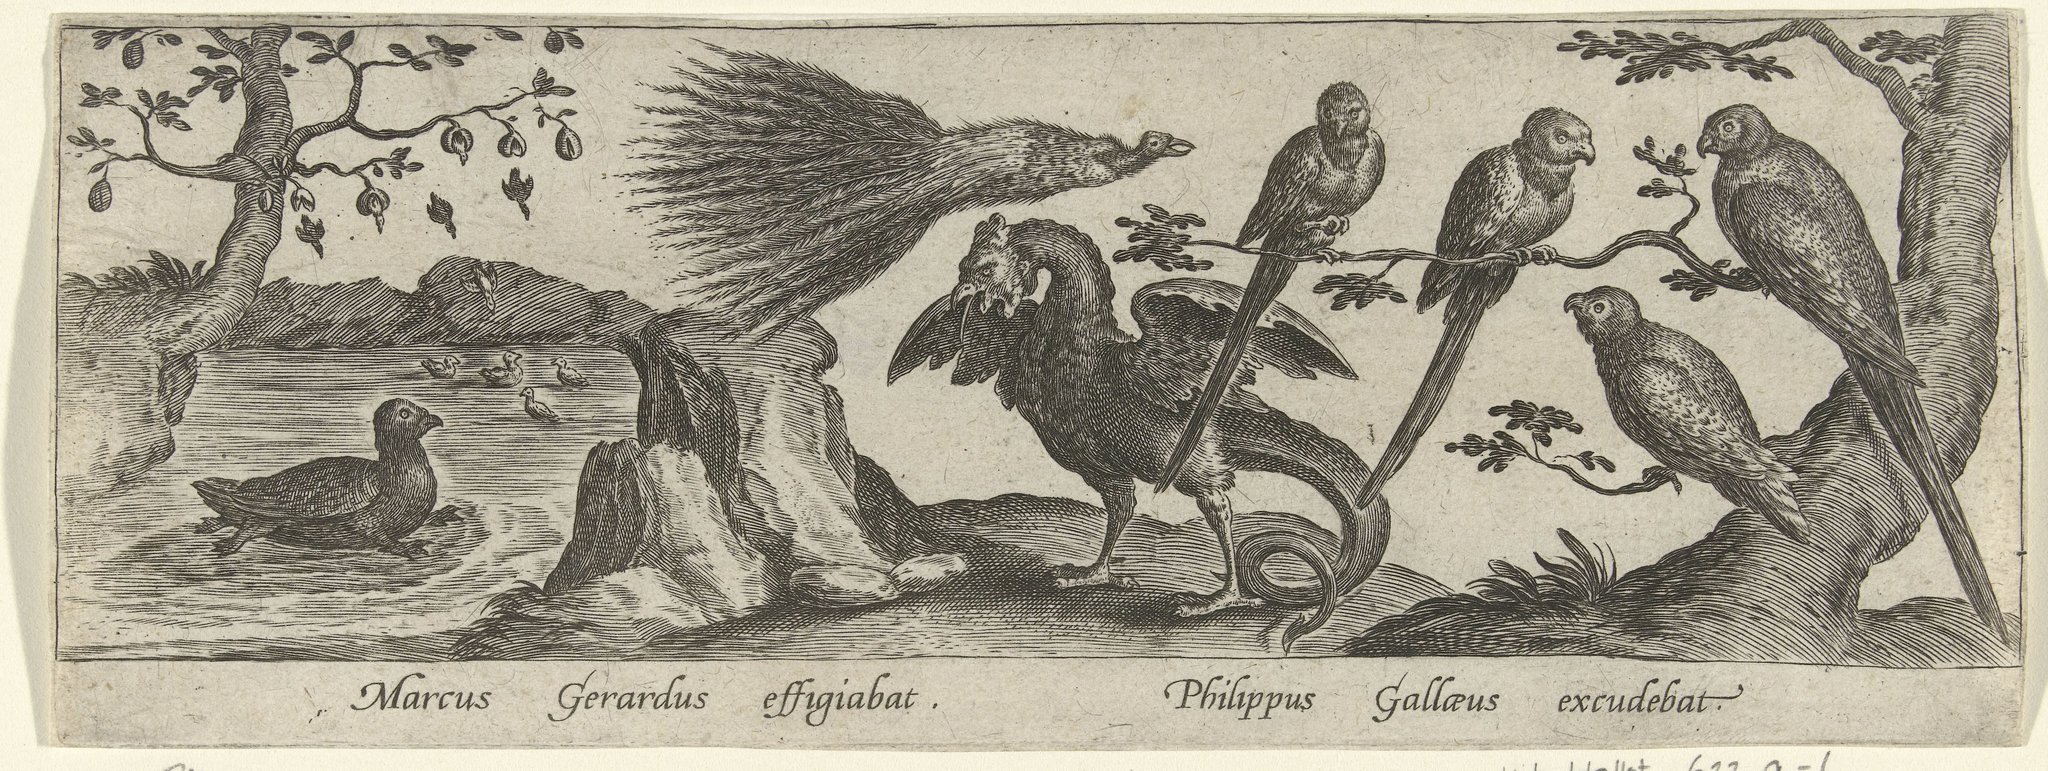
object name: print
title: Vogels en vlinders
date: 1547-1590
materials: paper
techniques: engraving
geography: antwerp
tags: ornamental birds: parrot, ornamental birds: bird of paradise - ff - fabulous animals, basilisk (cock with posterior of snake), water-birds: duck - ff - fabulous animals (sometimes wrongly called 'grotesques'); 'mostri' (ripa)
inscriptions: collector's mark: Lugt 2760, collector's mark: Lugt 2228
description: Vier papegaaien in een boom, centraal een basilisk en een paradijsvogel, links eend met vier poten en enkele eendenkuikens die uit bloemen groeien. De prent maakt deel uit van een prentserie over vogels en vlinders.